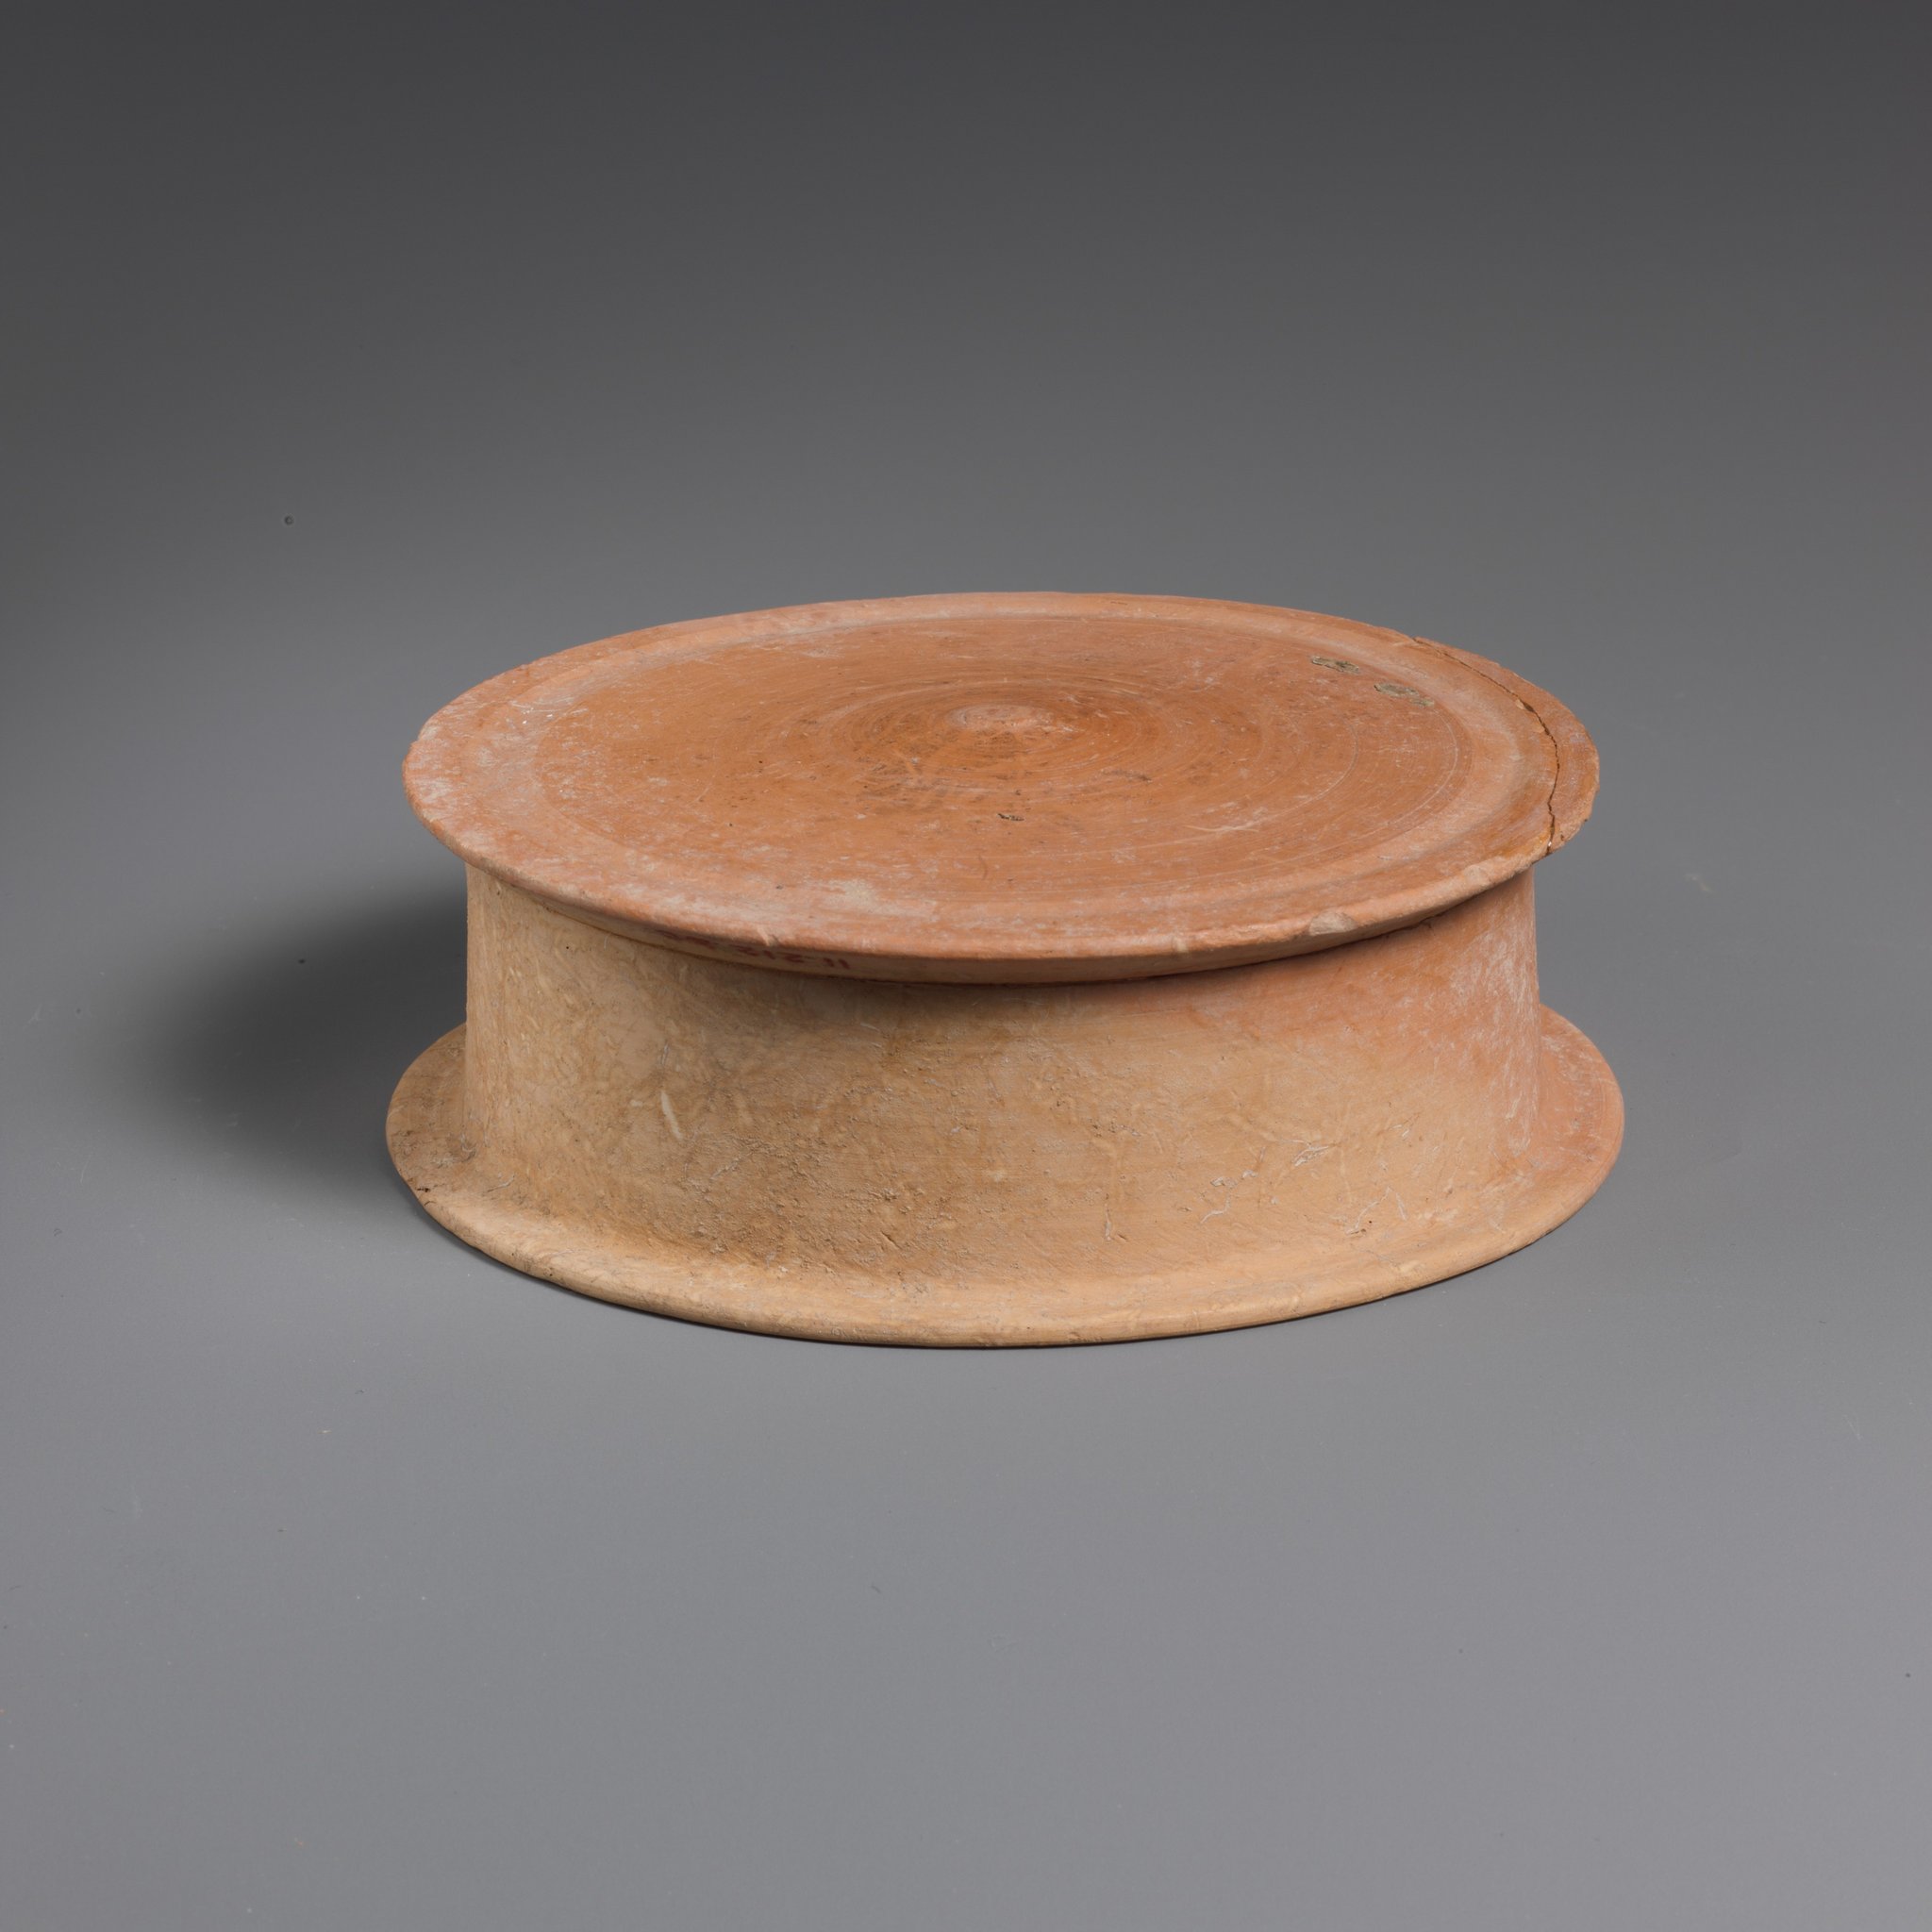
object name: statue base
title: Terracotta statuette base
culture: greek, south italian, tarentine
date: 300-201 BCE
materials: terracotta